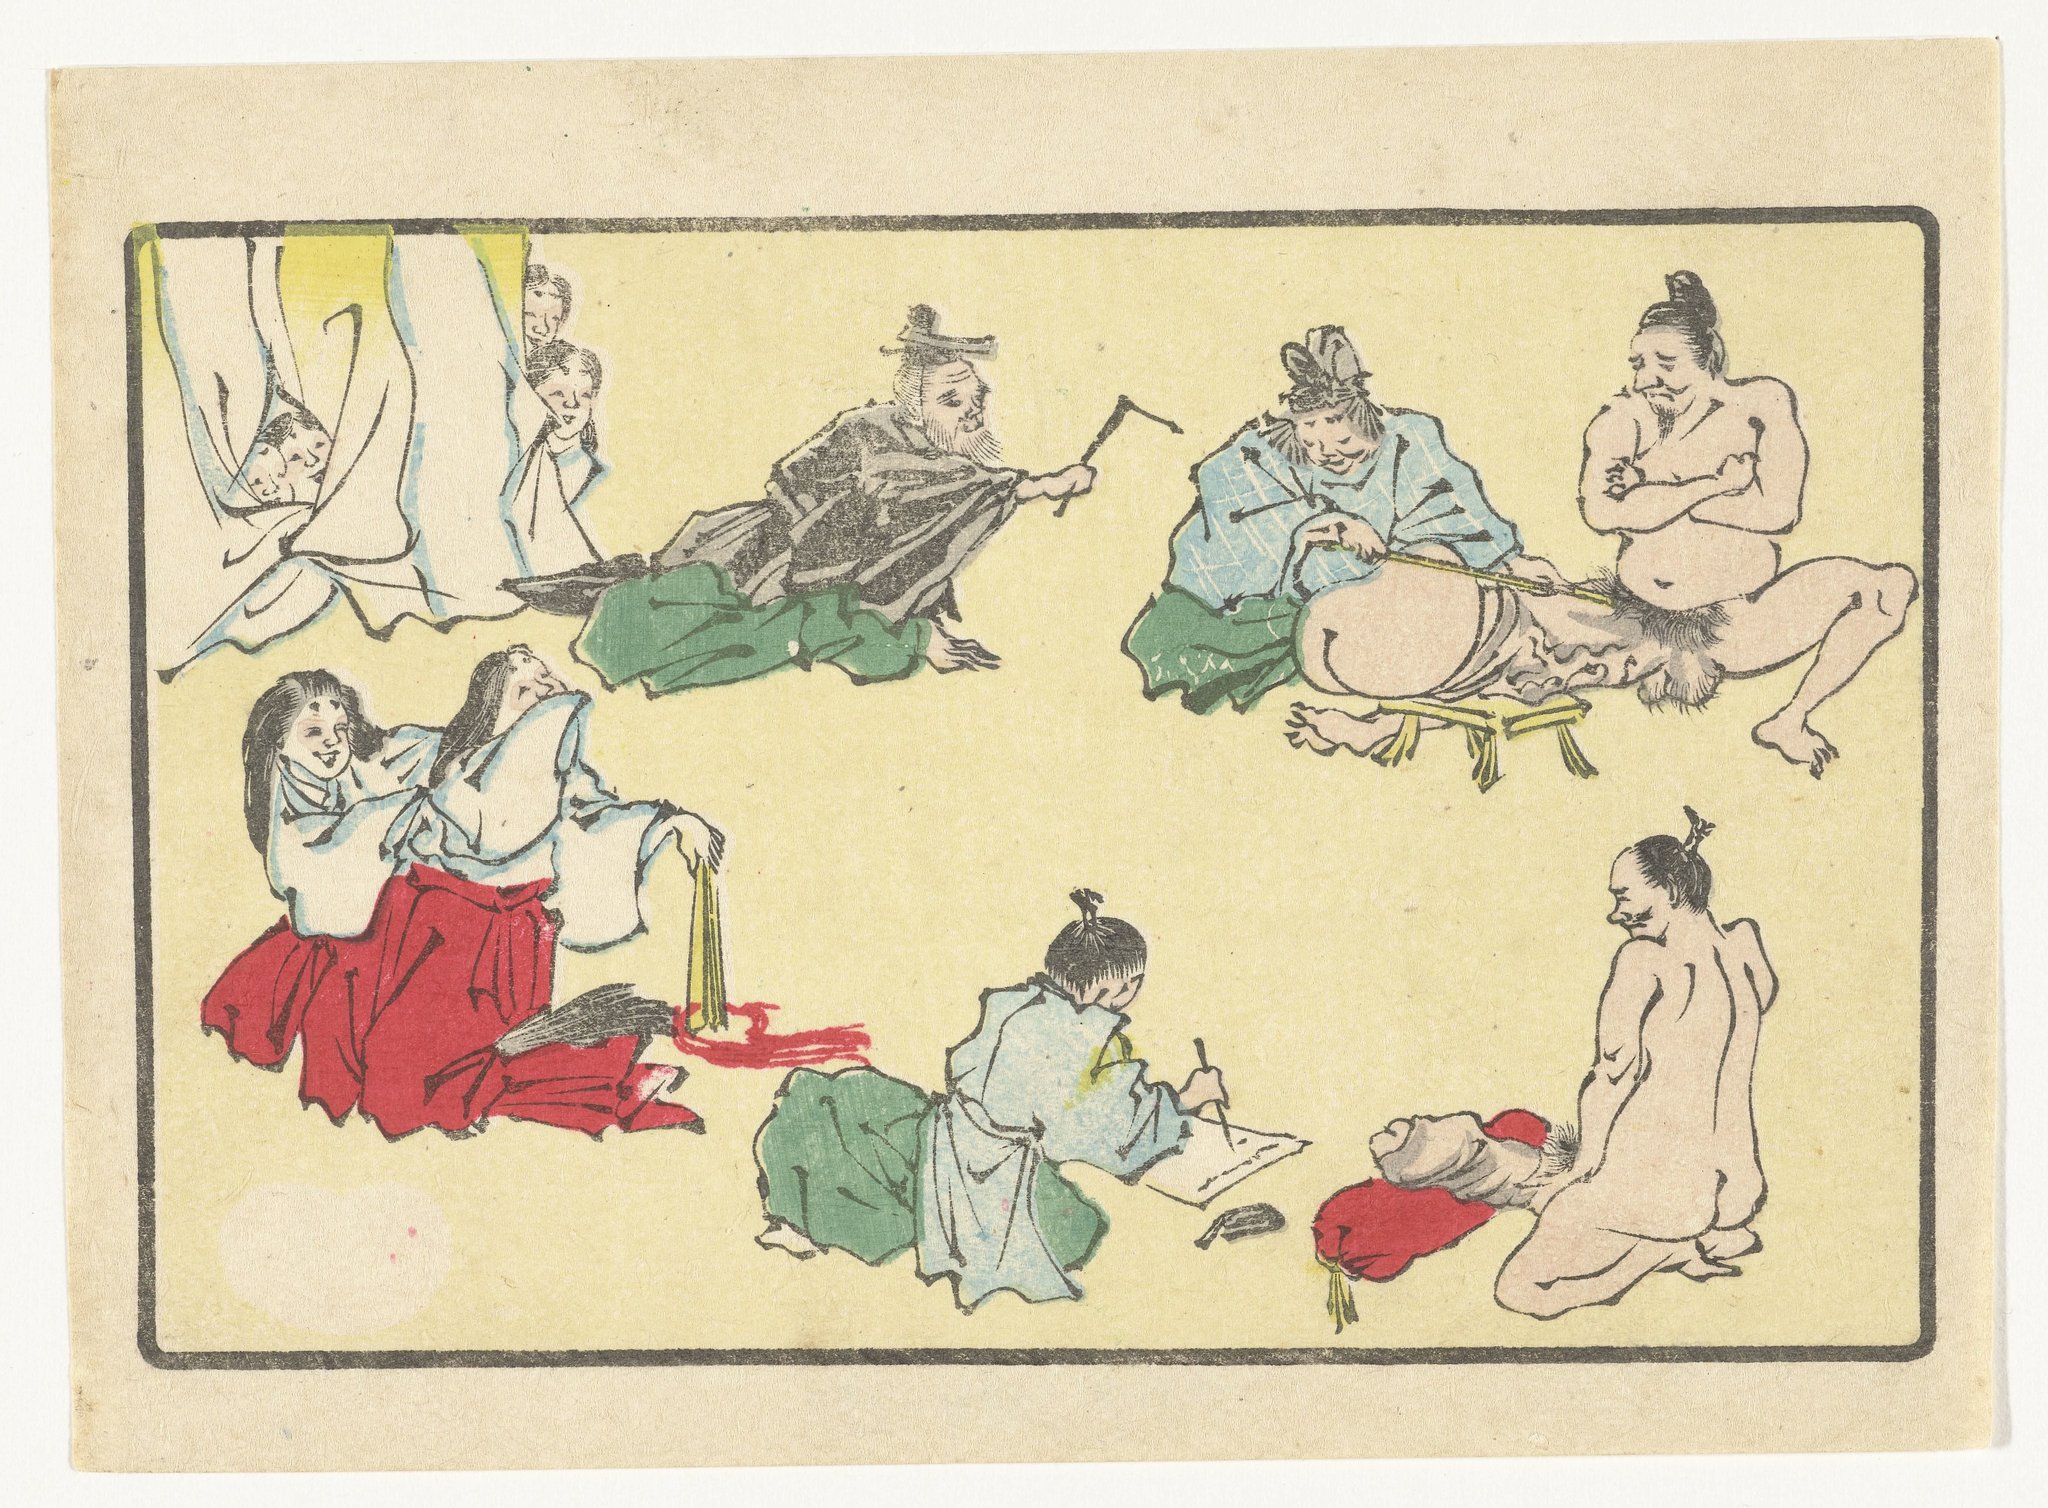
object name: print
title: Penis opmetingen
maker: kawanabe kyôsai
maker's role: draughtsman, print maker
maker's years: 1831-1889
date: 1870-1880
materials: paper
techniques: woodcut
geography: japan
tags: laughing, spying on someone, penis, phallus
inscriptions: collector's mark: Lugt 2228, collector's mark: Lugt 2760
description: Humoristisch erotische prent; van twee naakte mannen wordt de penis opgemeten en beschreven, onder toeziend oog van twee giechelende hofdames en tussen gordijnen glurende vrouwen.